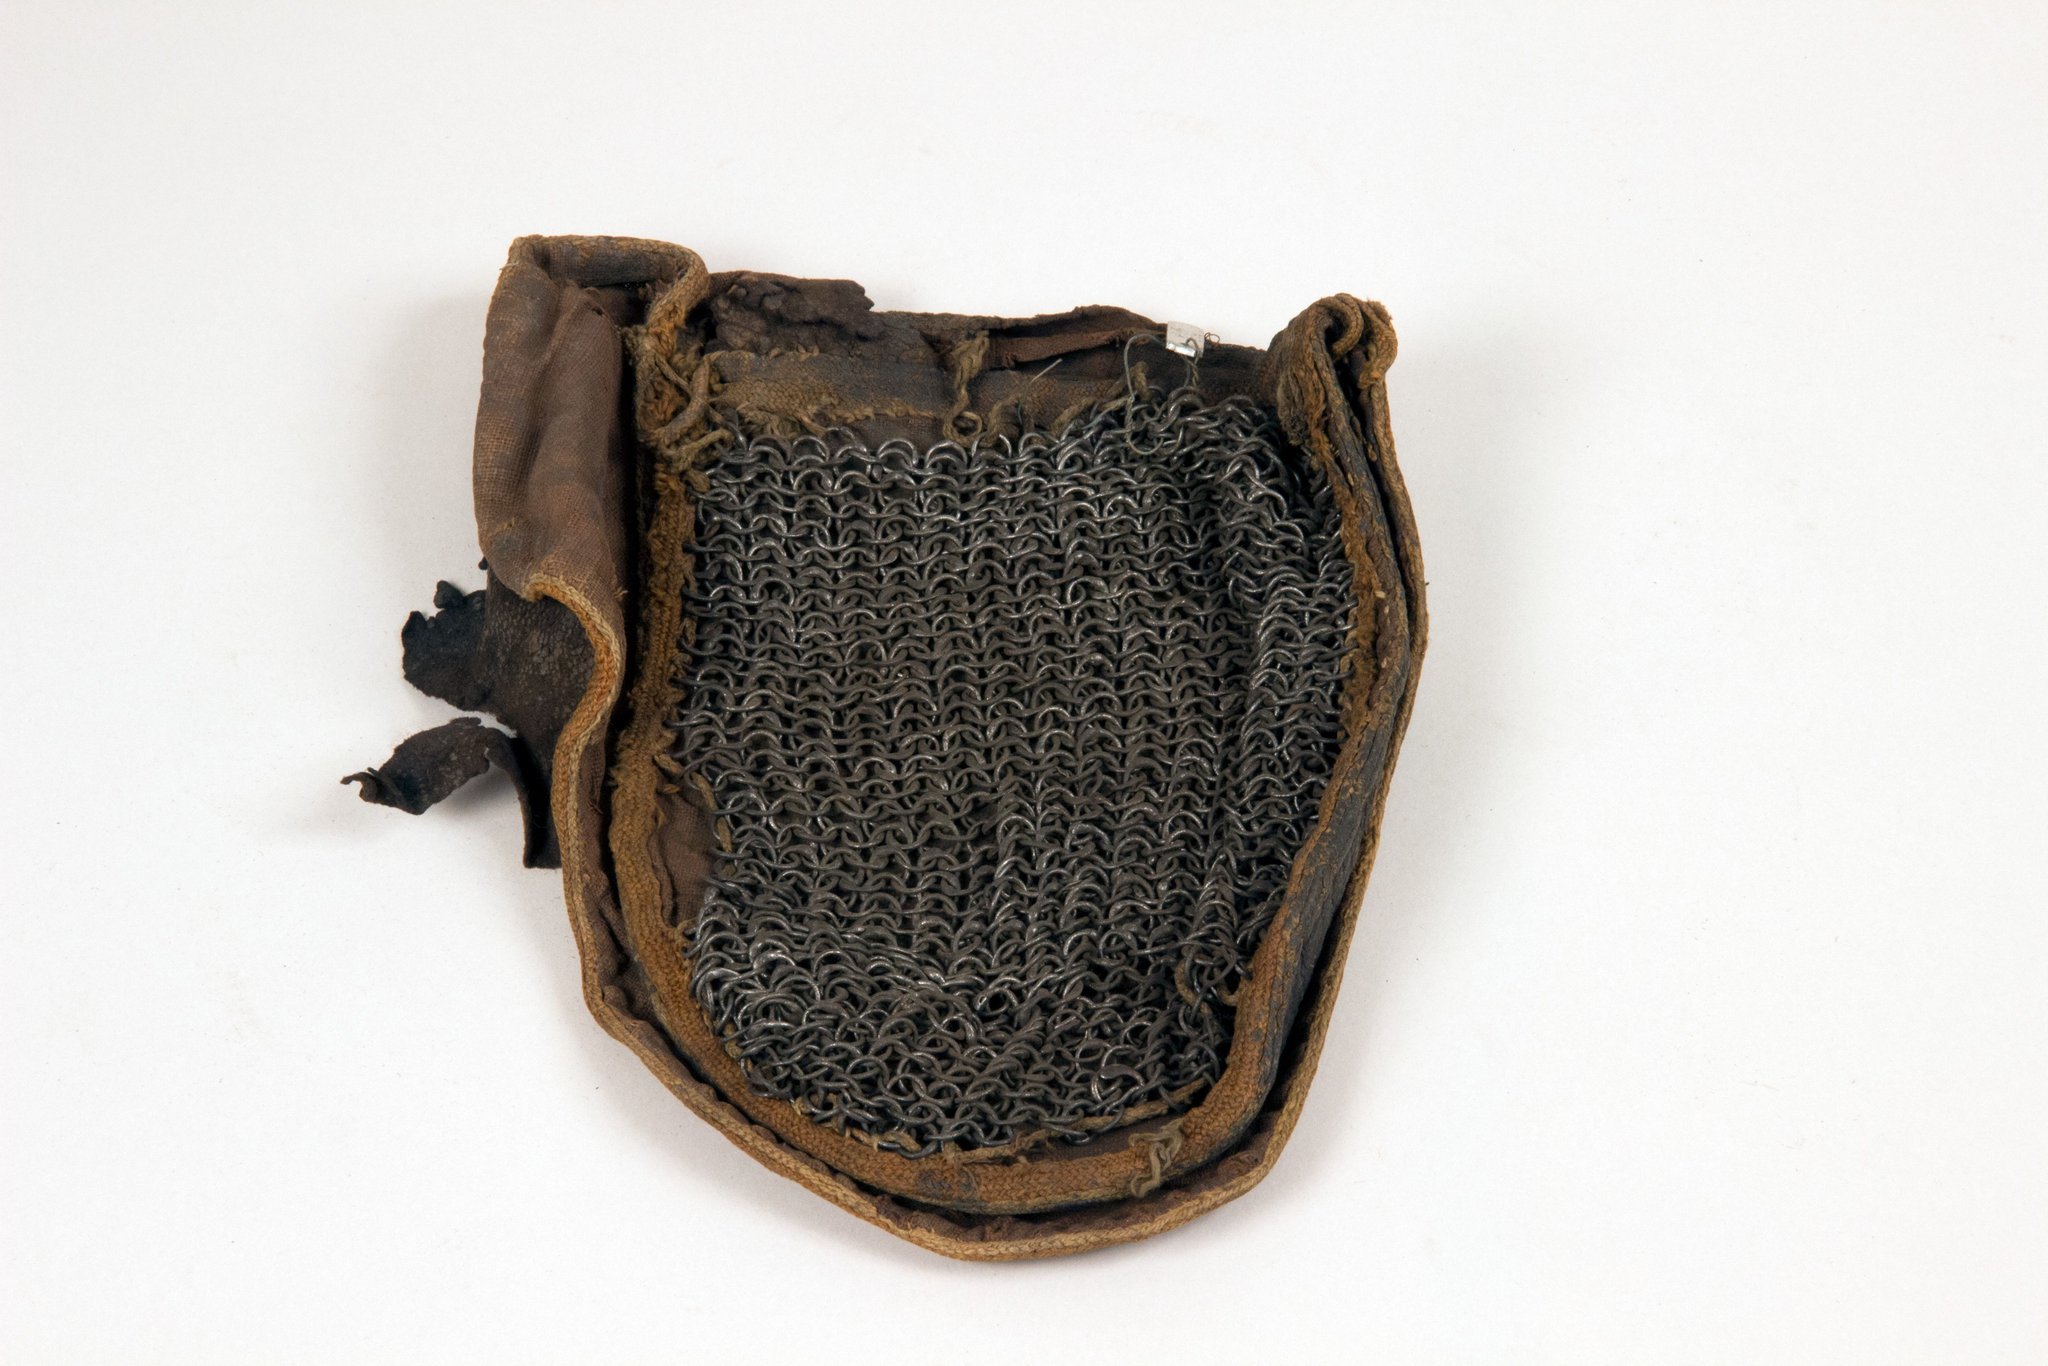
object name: gauntlet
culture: turkish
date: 1601-1700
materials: iron, leather, linen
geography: ottoman empire